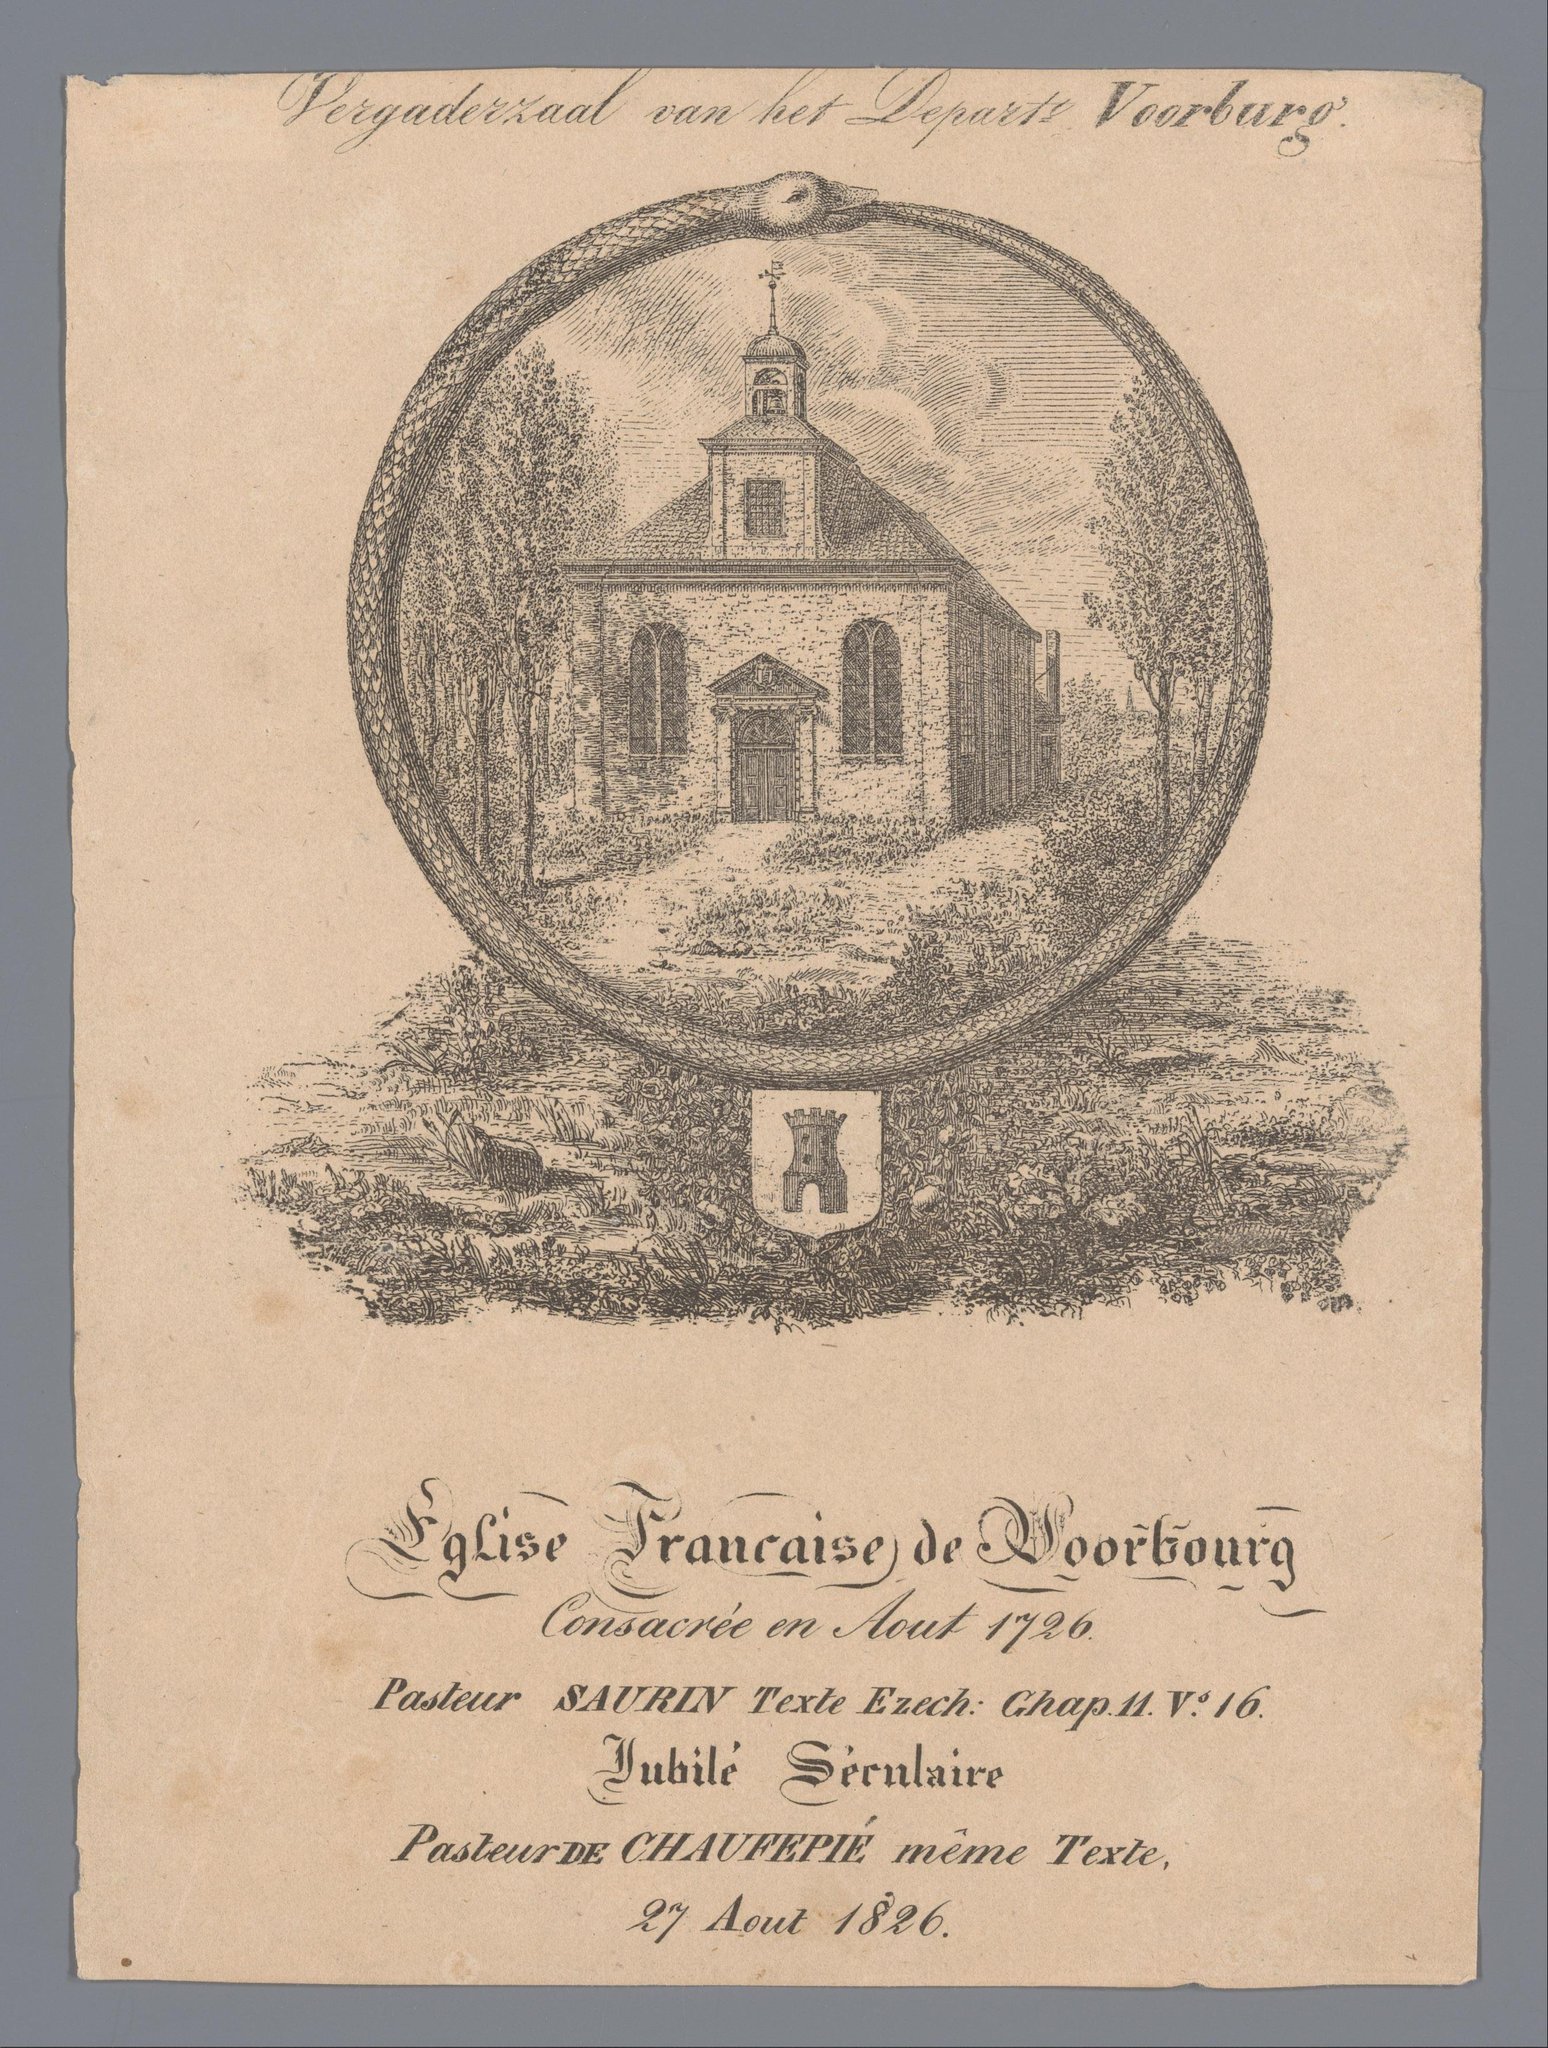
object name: print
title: Vergaderzaal van het Departe. Voorburg; Eglise Francaise de Voorburg (...)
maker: Anonymous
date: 1800-1850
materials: paper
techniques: lithograph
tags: church (exterior), voorburg